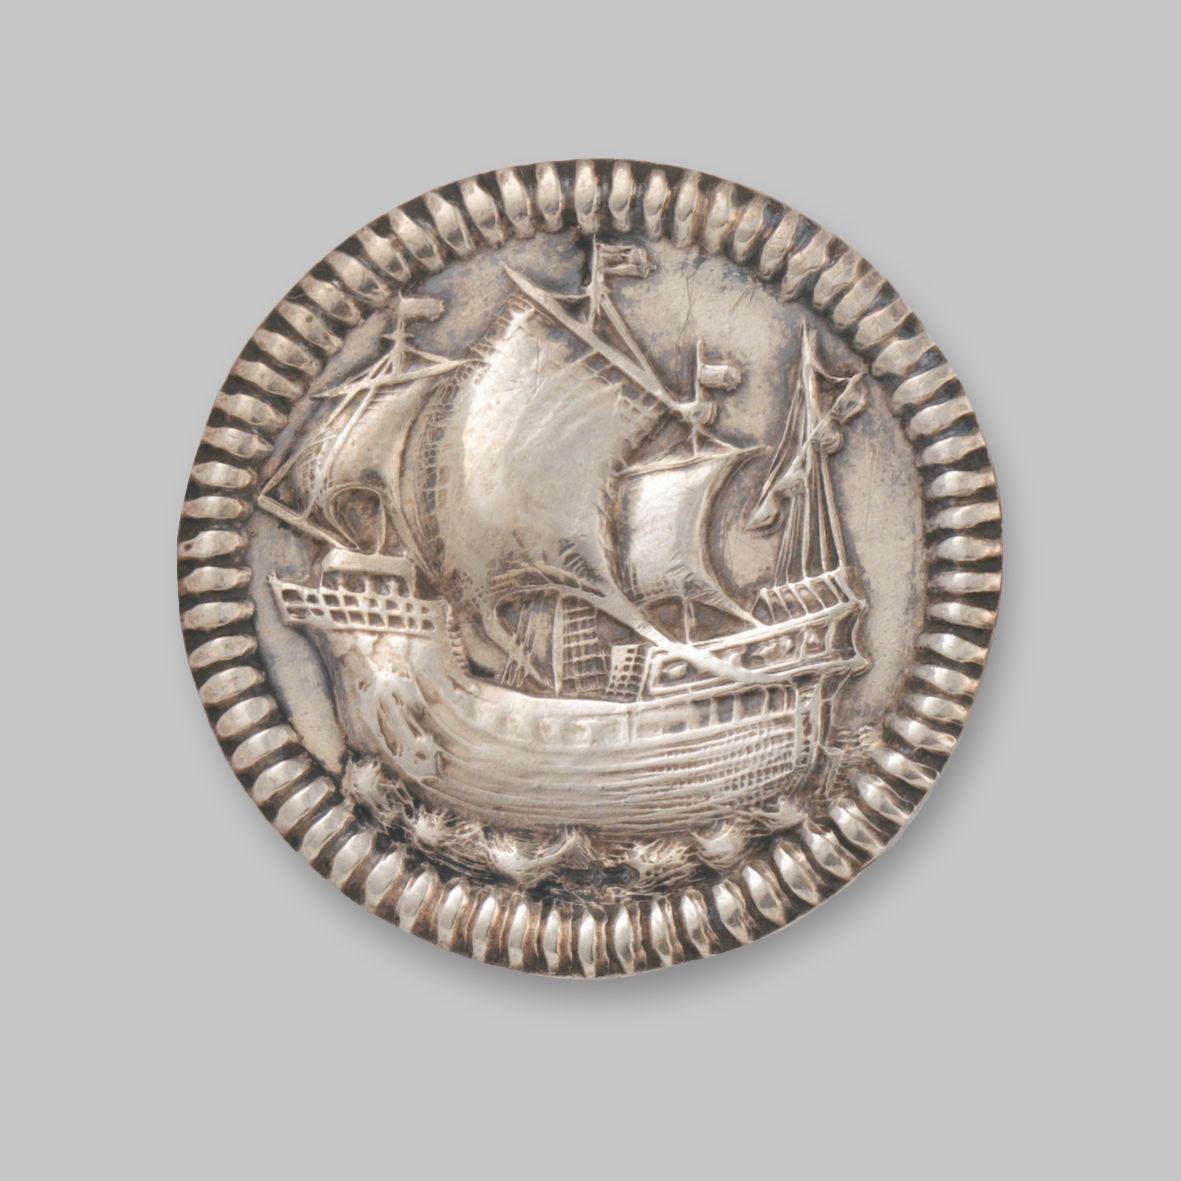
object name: button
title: Knoop met voorstelling van een driemaster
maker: Anonymous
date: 1850-1900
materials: silver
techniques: casting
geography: netherlands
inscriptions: alloy mark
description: Knoop van gegoten zilver, rond, met op de voorzijde een driemaster omgeven door een geribde rand. Aan de achterzijde is een uit gebogen draad vervaardigd oog bevestigd.